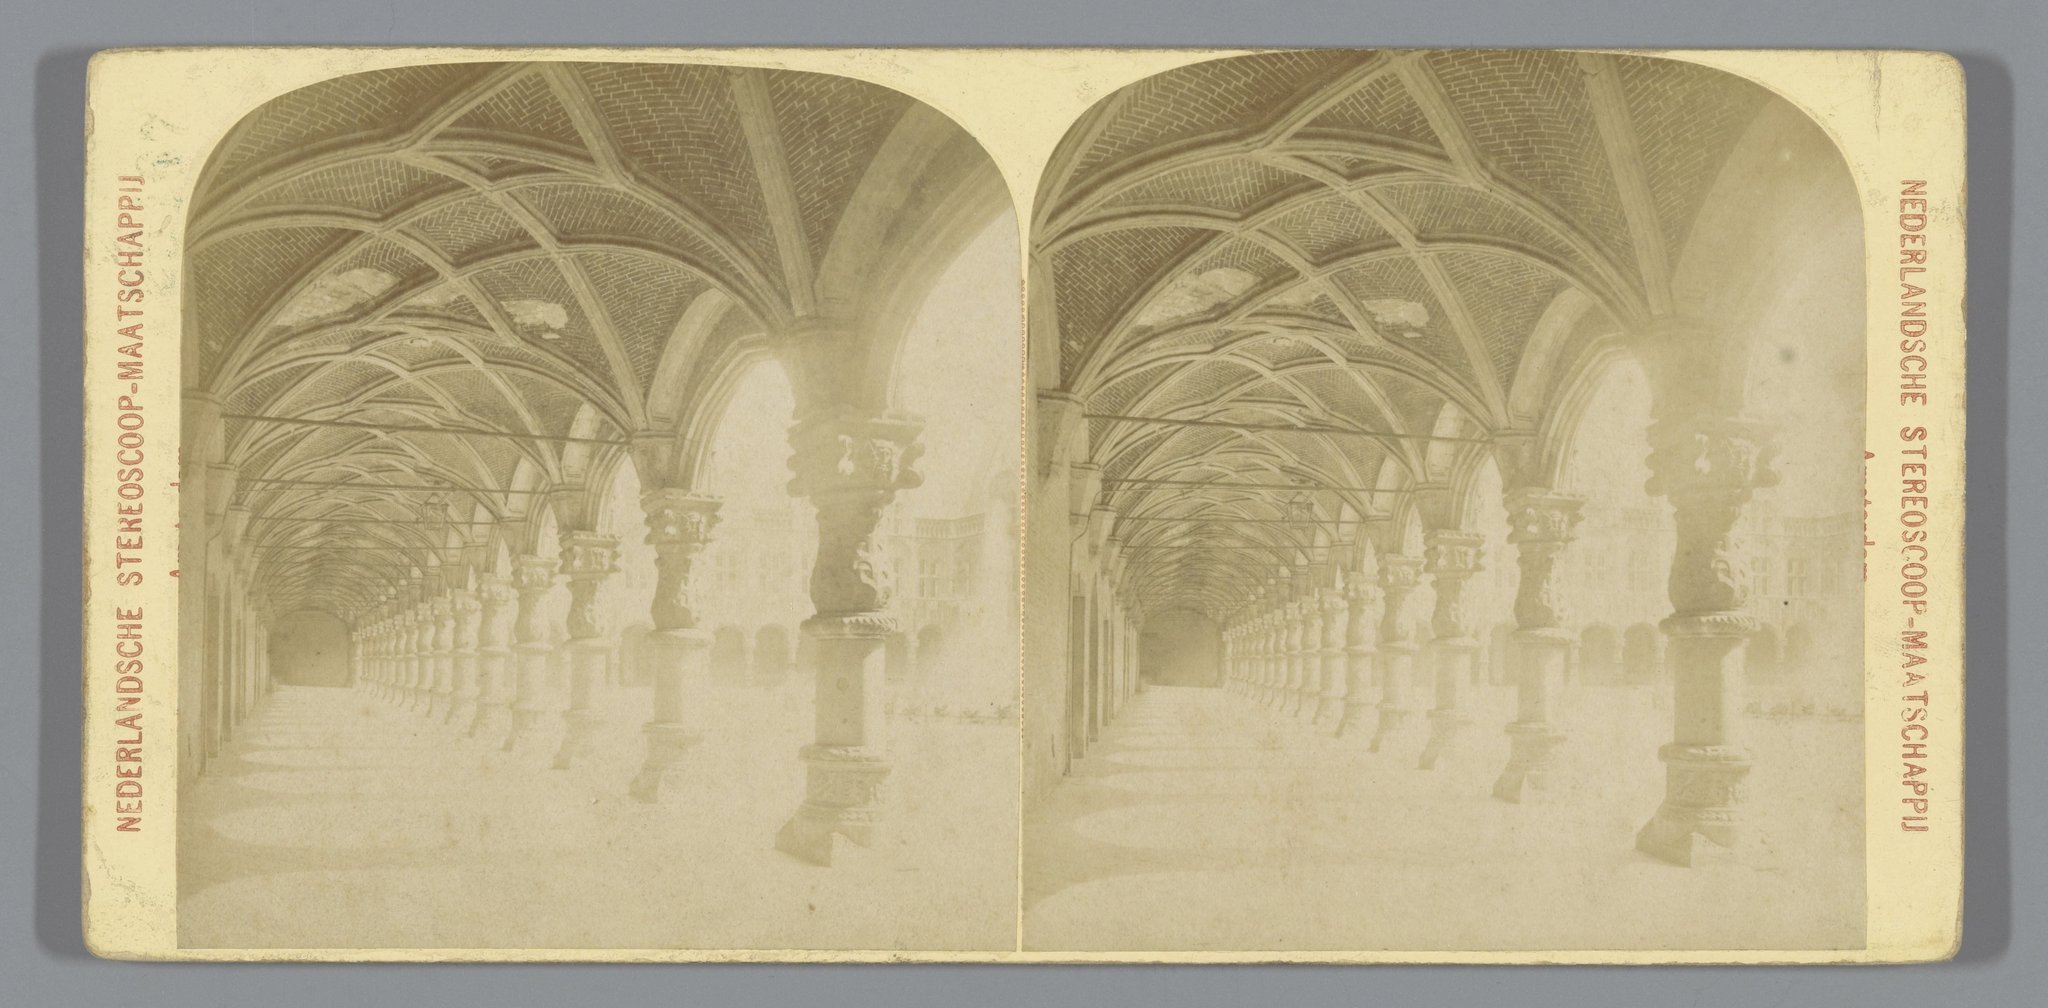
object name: stereograph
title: Kloostergang van de Grande Chartreuse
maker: j.g. beers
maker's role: fotograaf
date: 1860-1880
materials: cardboard, photographic support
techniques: albumen print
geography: amsterdam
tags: cloisters ~ monastery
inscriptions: inscription: ‘La grande chartreuse’